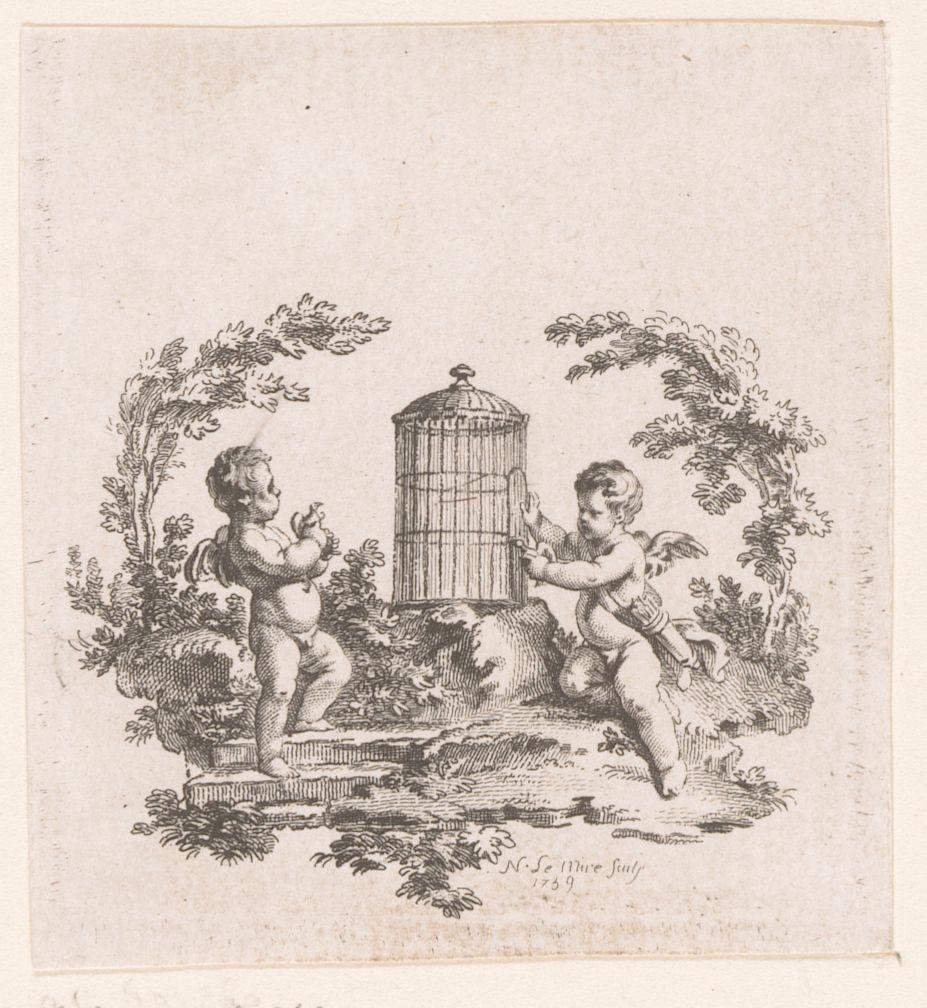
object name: print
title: Twee putti bij een vogelkooi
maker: noël le mire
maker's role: print maker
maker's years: 1724-1801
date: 1759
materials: paper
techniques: etching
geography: france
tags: empty bird cage, cupids: 'amores', 'amoretti', 'putti'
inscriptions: date